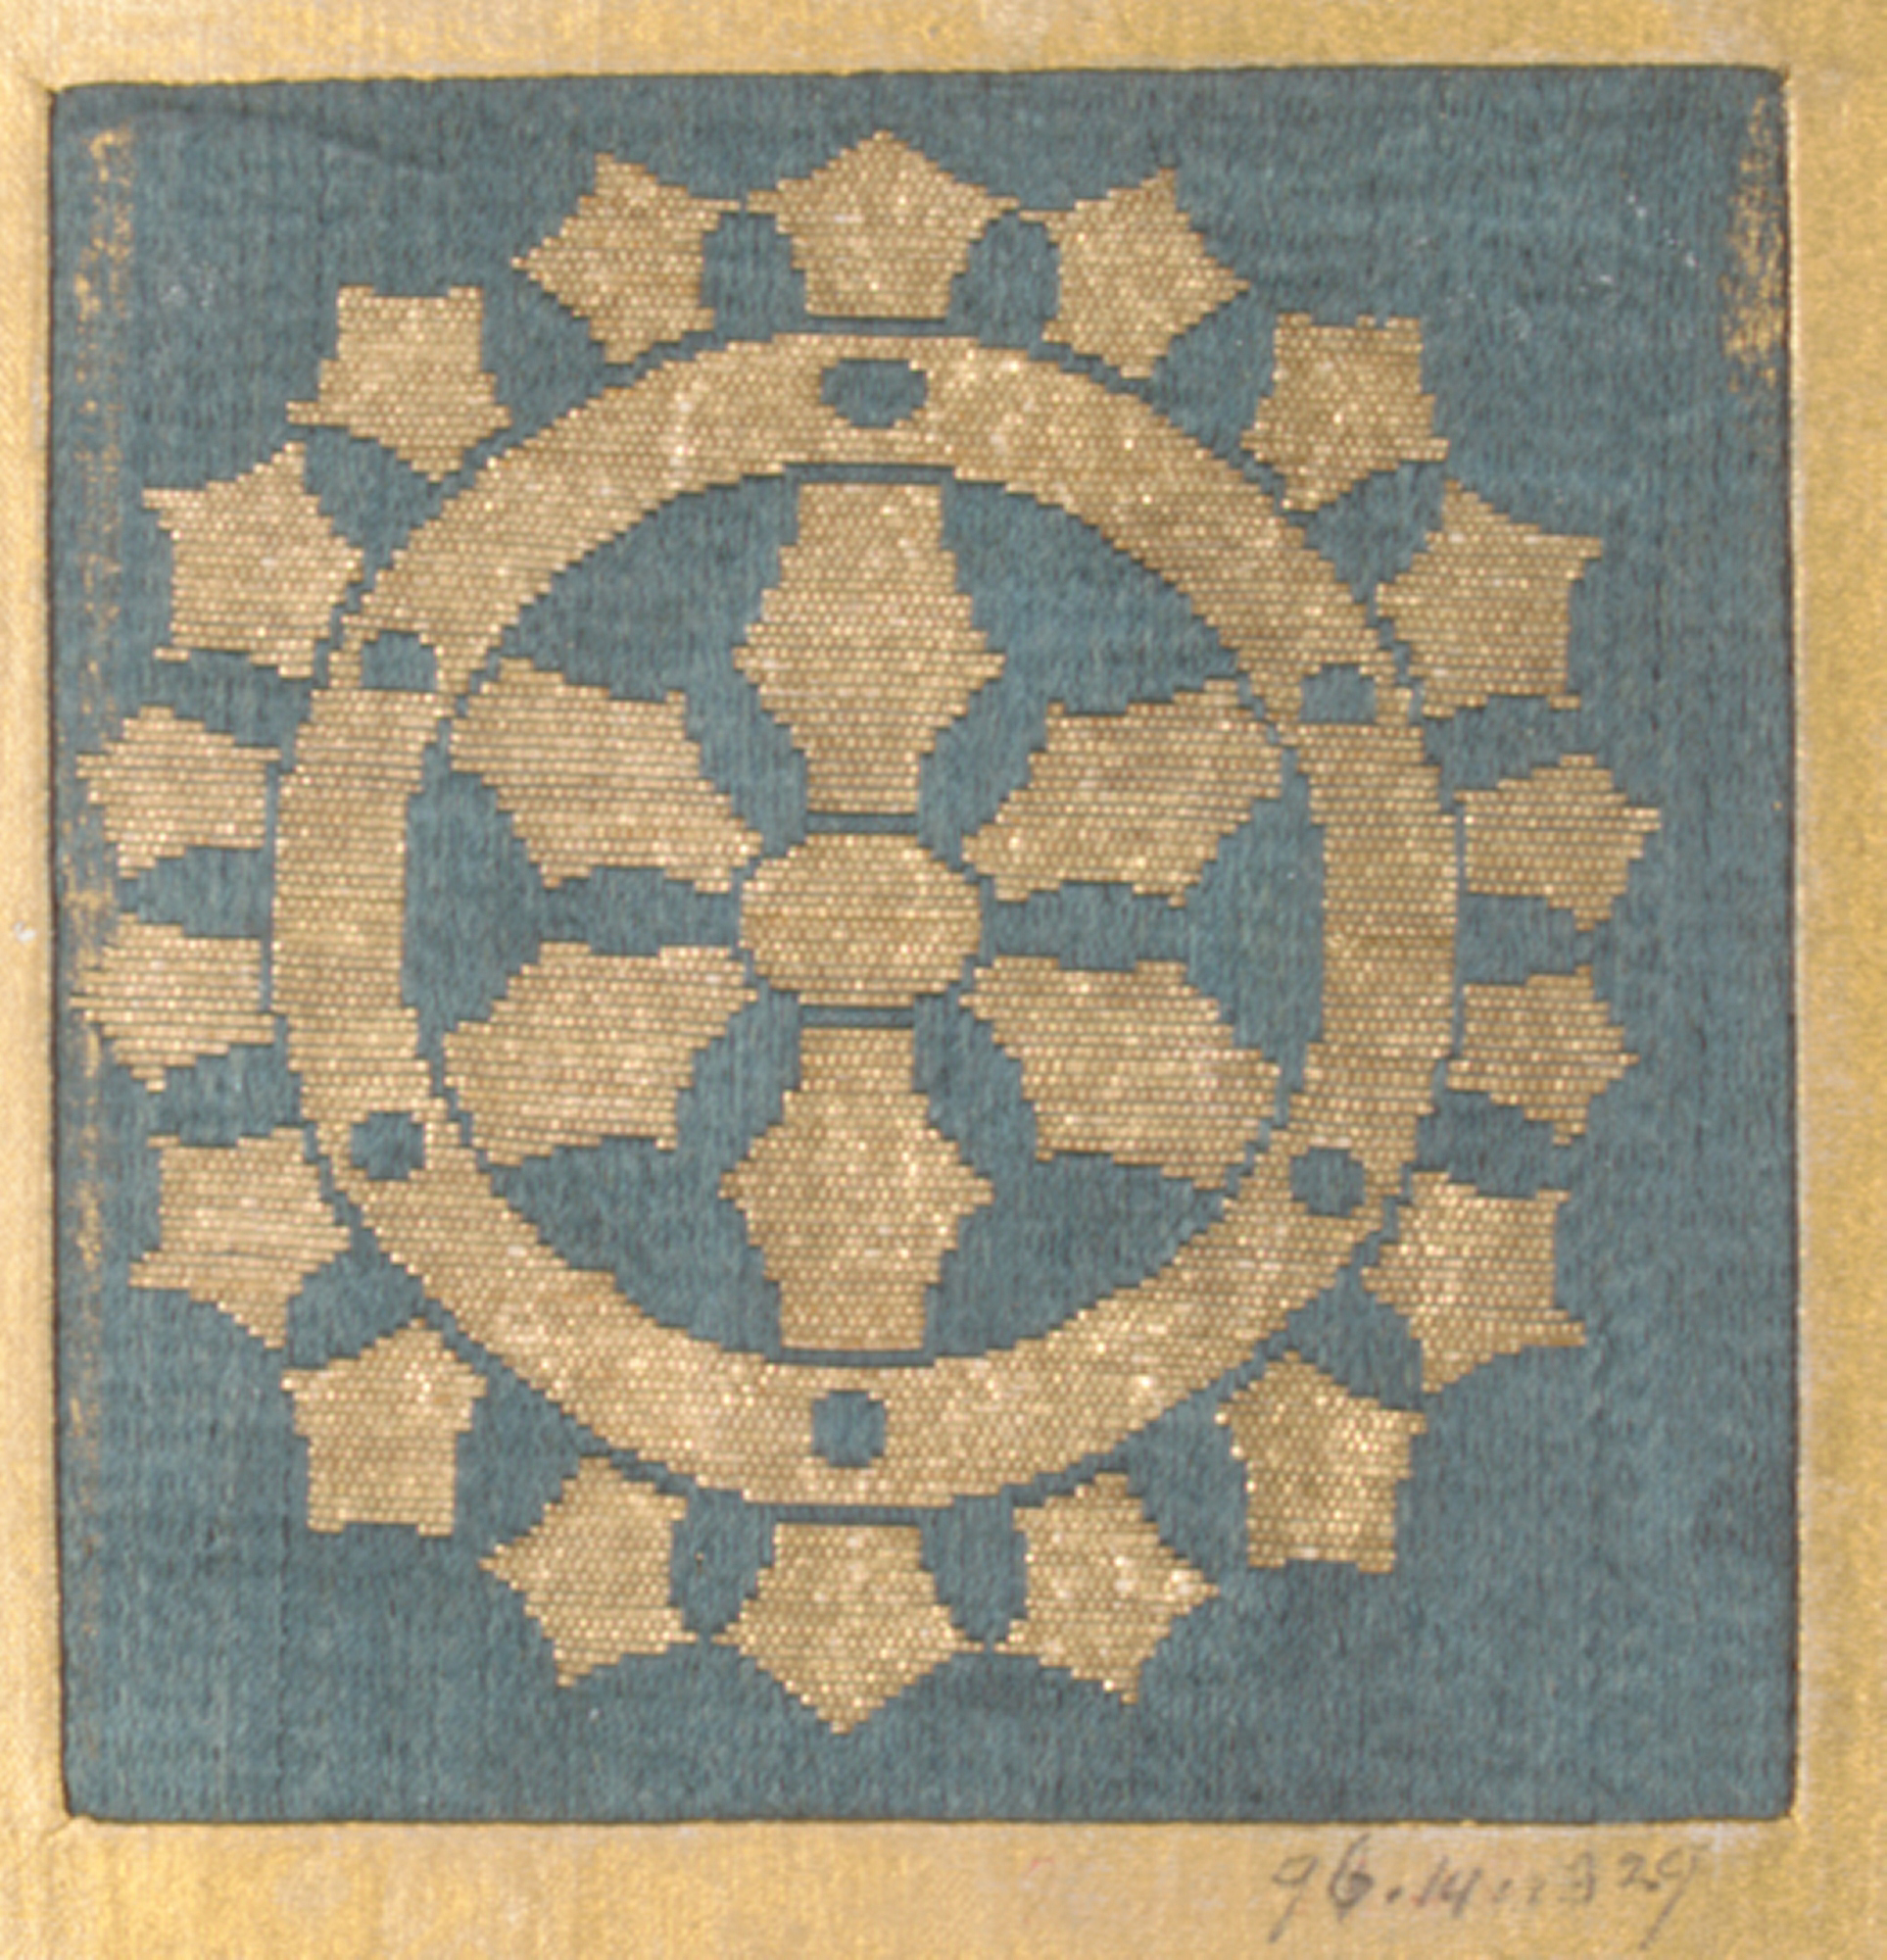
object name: piece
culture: japanese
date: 1701-1900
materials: silk